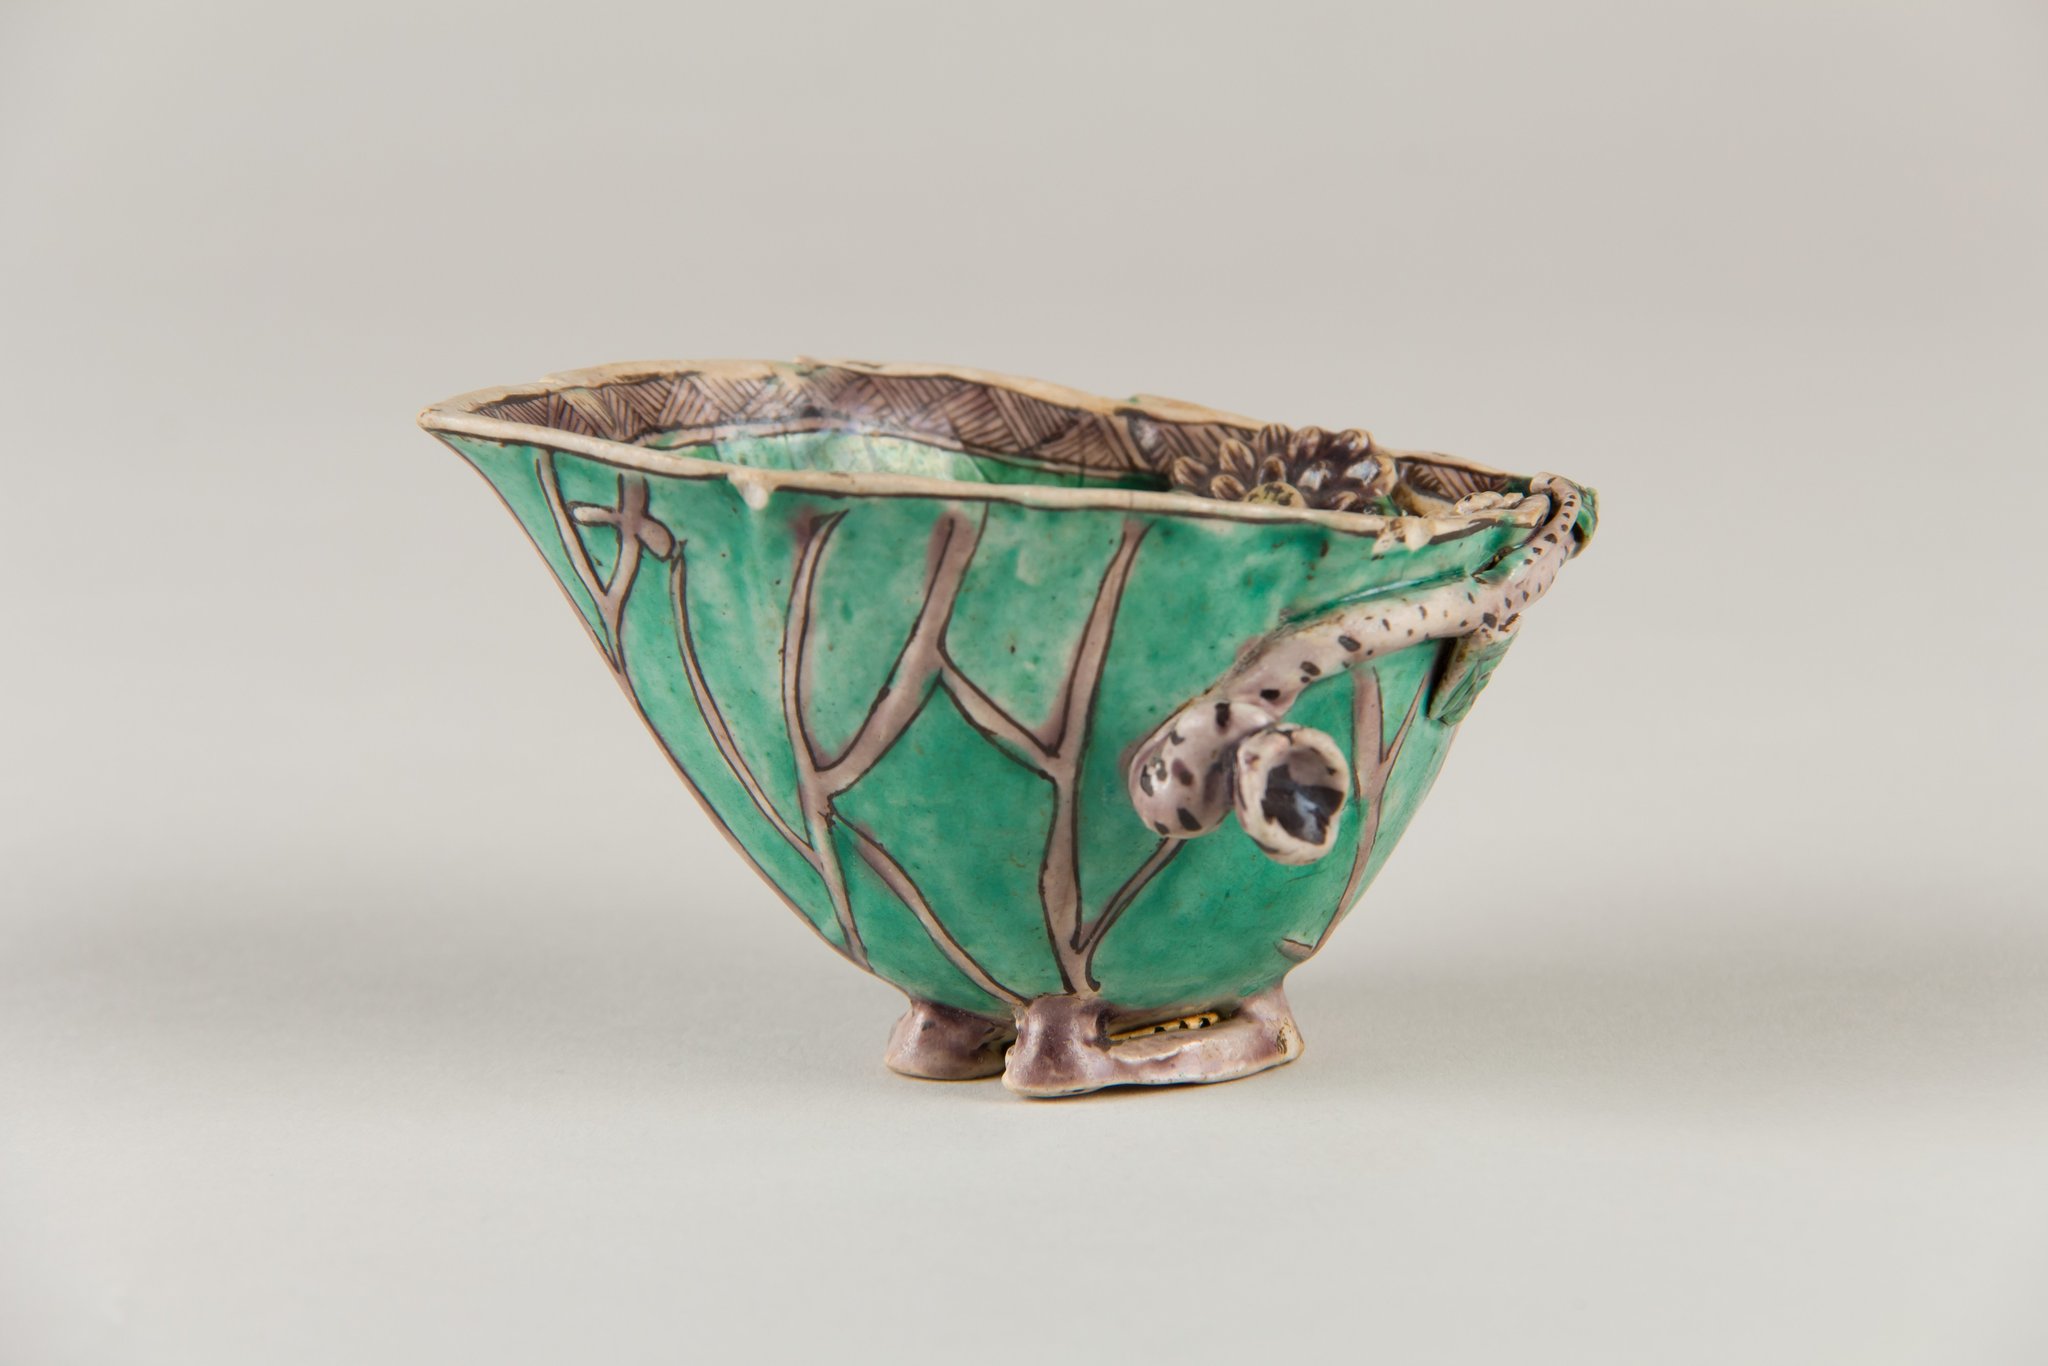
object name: cup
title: Cup in form of flowers and leafs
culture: chinese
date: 1667-1733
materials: enamel, porcelain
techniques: overglaze, painting, polychrome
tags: flowers